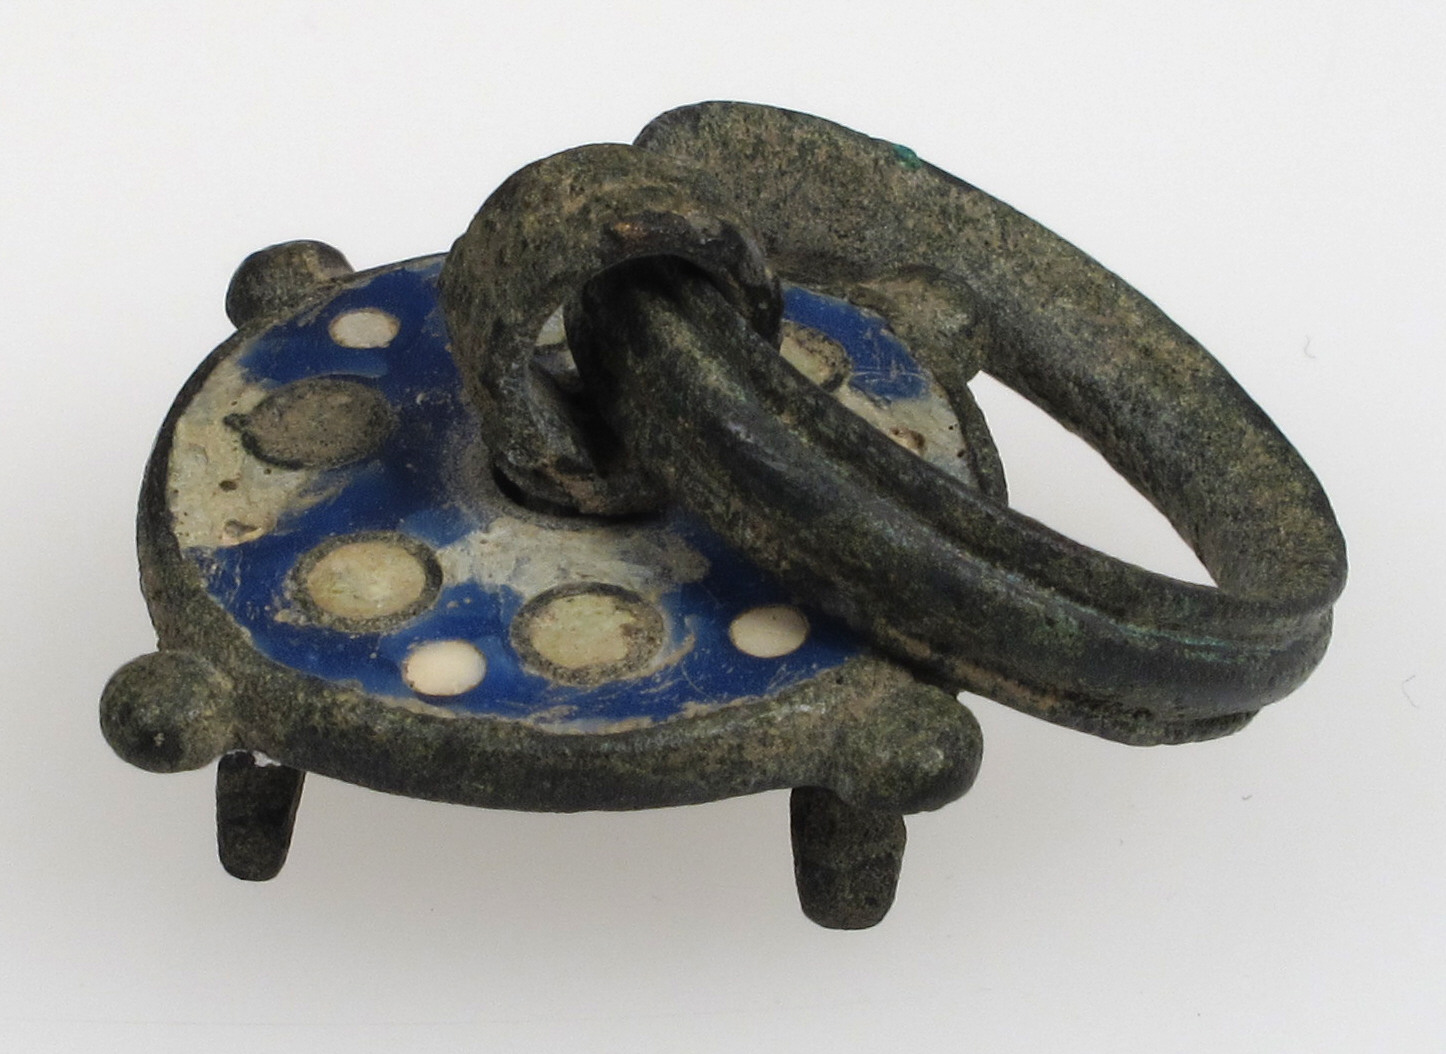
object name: vessel with lid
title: Vessel Lid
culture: roman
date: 101-300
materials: copper alloy, enamel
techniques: enamel